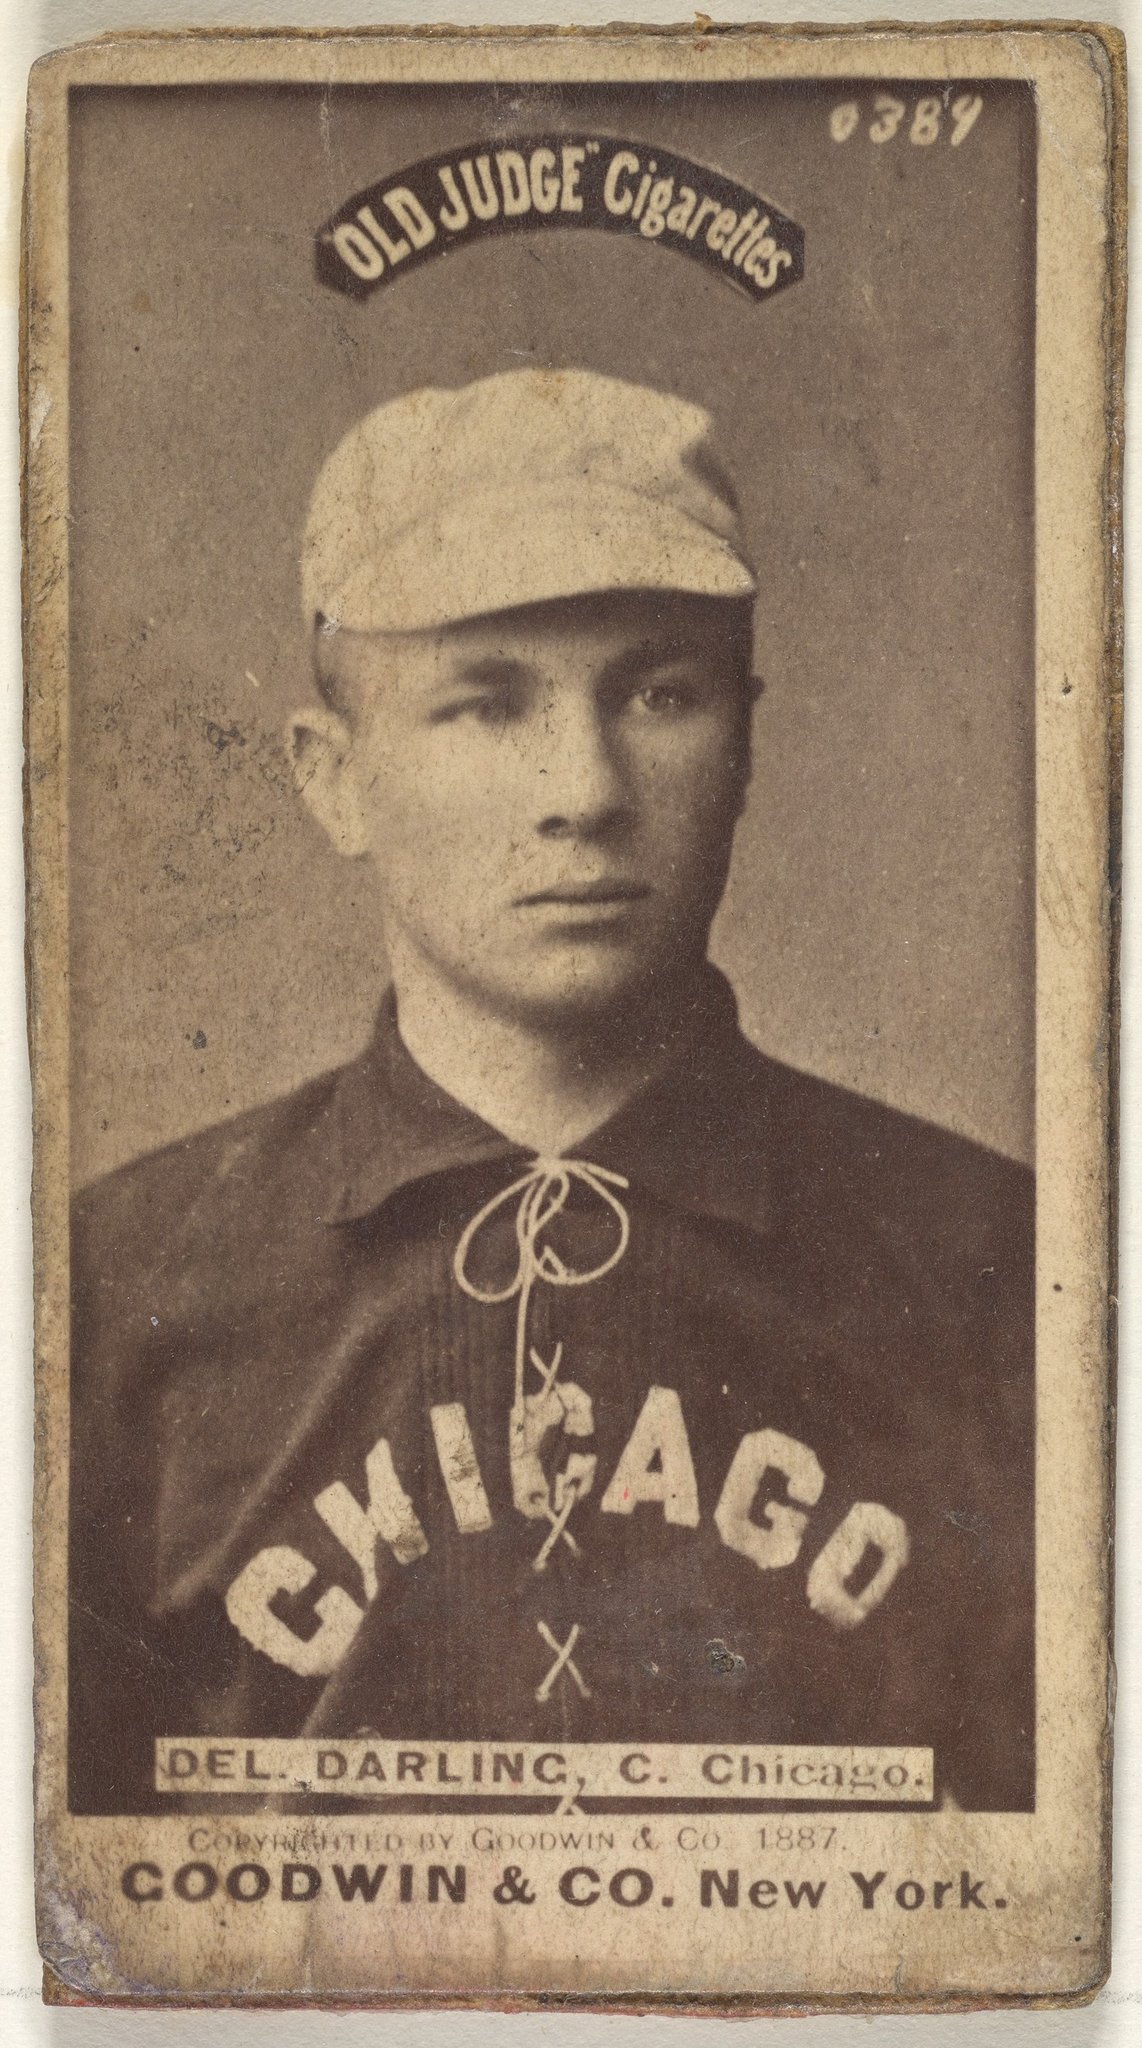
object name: baseball card, photograph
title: Dell Darling, Catcher, Chicago, from the Old Judge series (N172) for Old Judge Cigarettes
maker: goodwin & company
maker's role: publisher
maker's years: 1850-1950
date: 1887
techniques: albumen silver print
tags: men,portraits,baseball,athletes